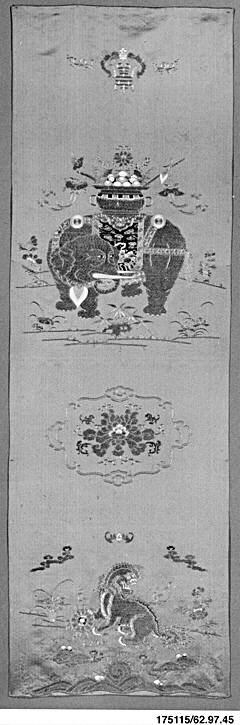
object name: chair strip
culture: chinese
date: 1701-1800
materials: feather, linen, metal thread, silk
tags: animals